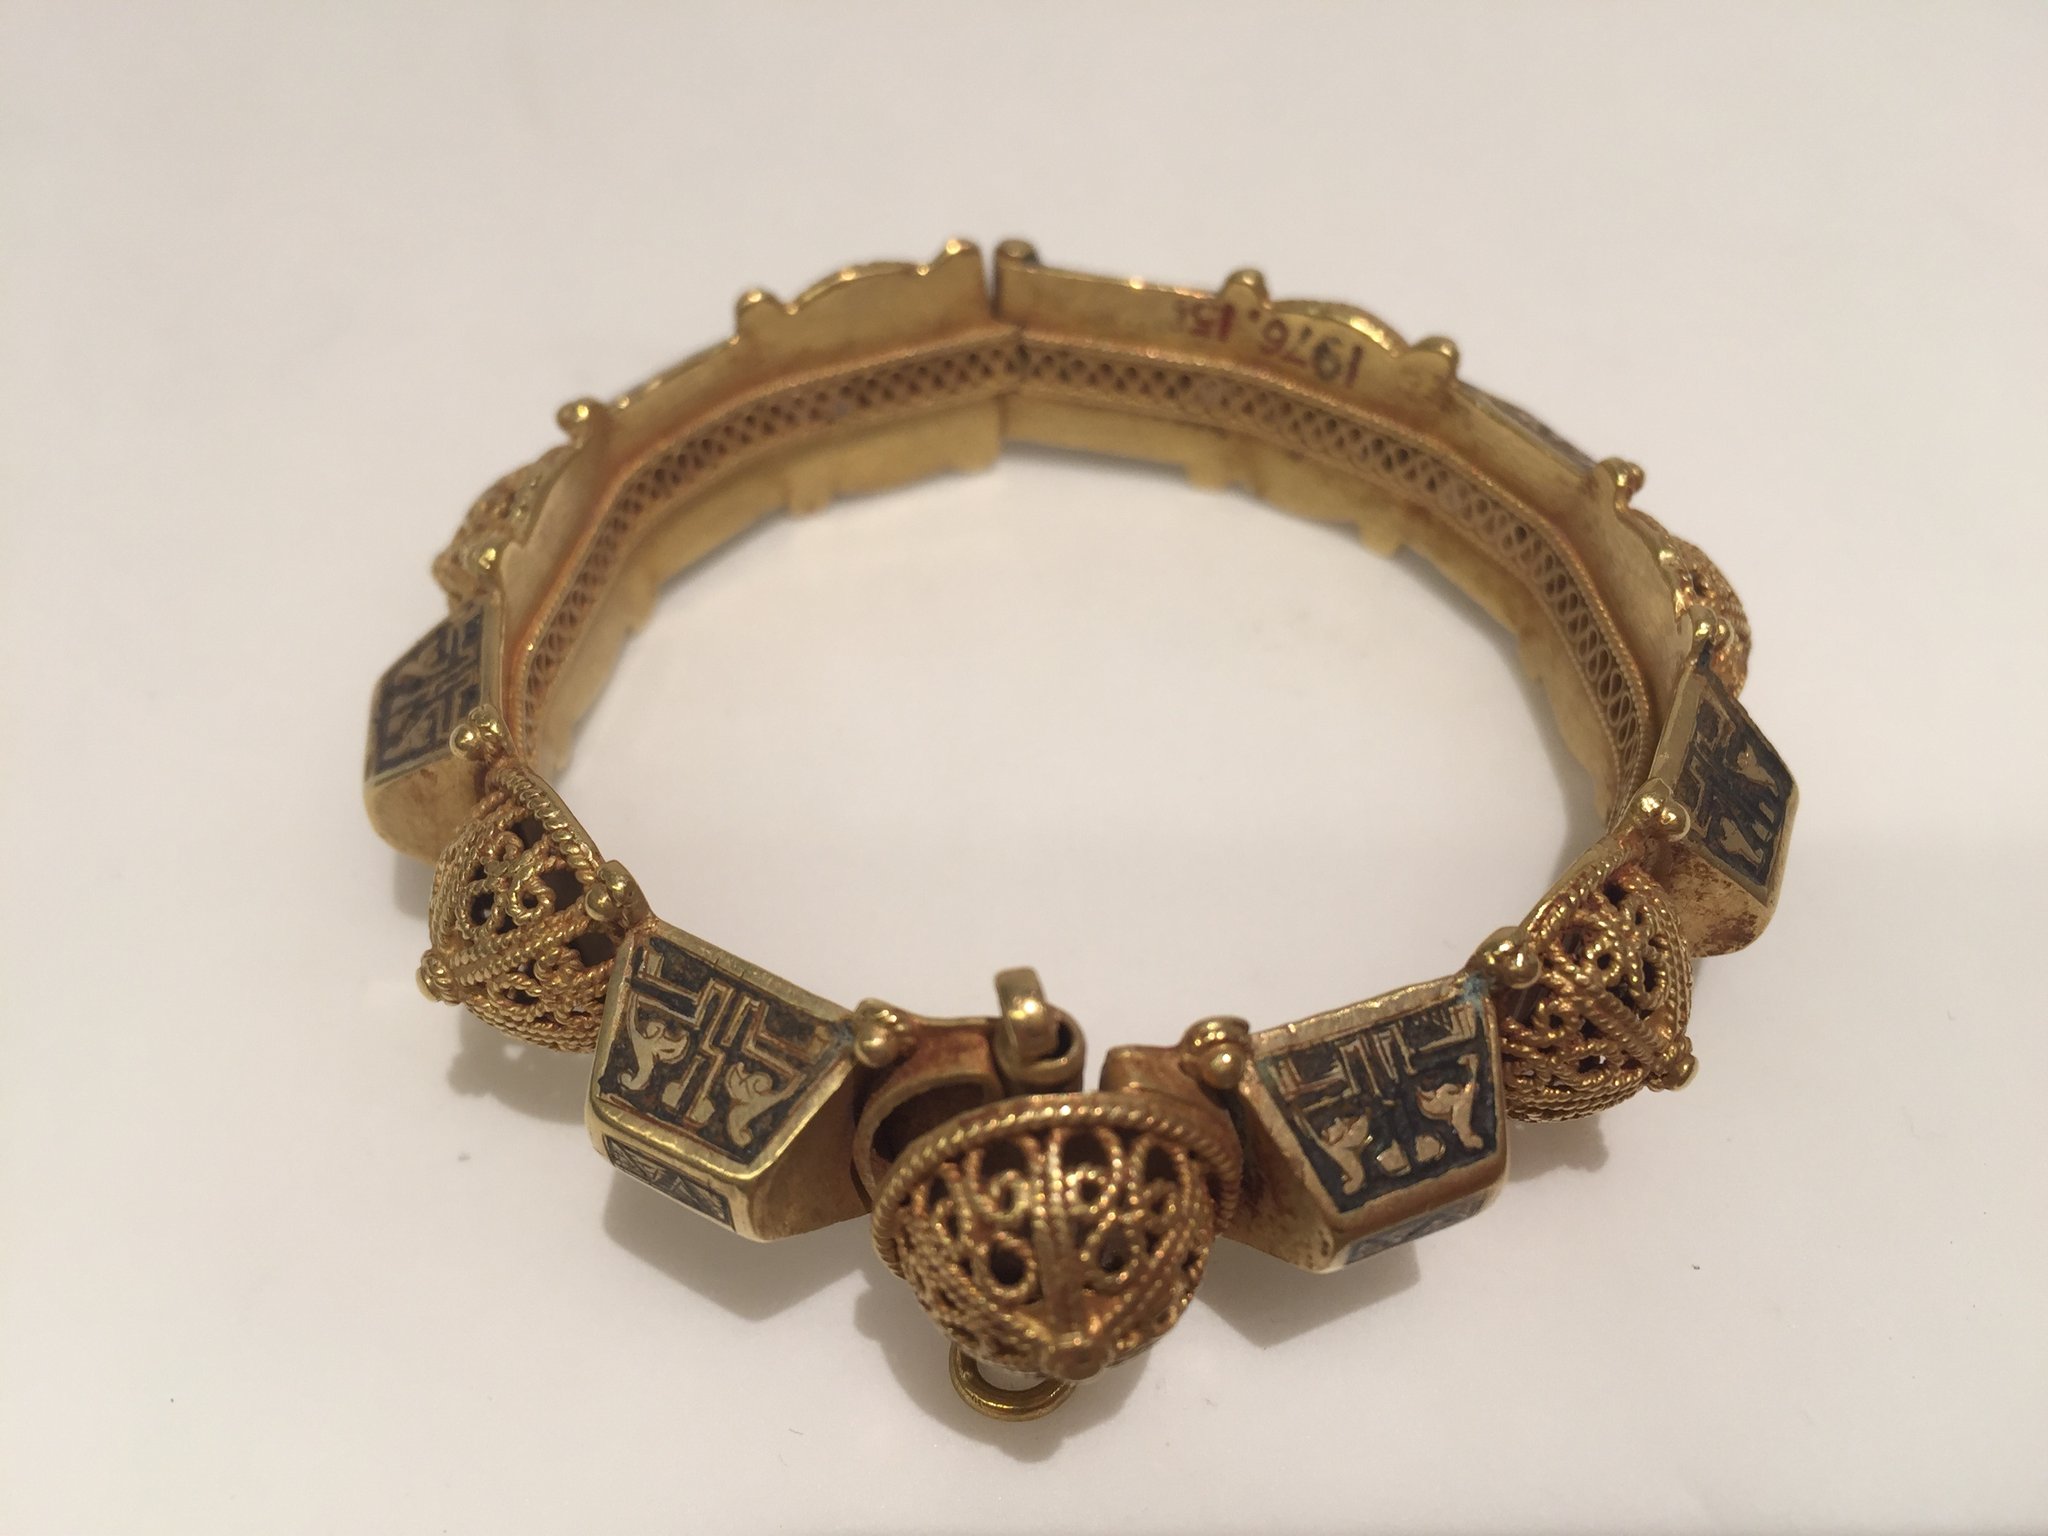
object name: bracelet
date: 1101-1200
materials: gold, niello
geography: iran